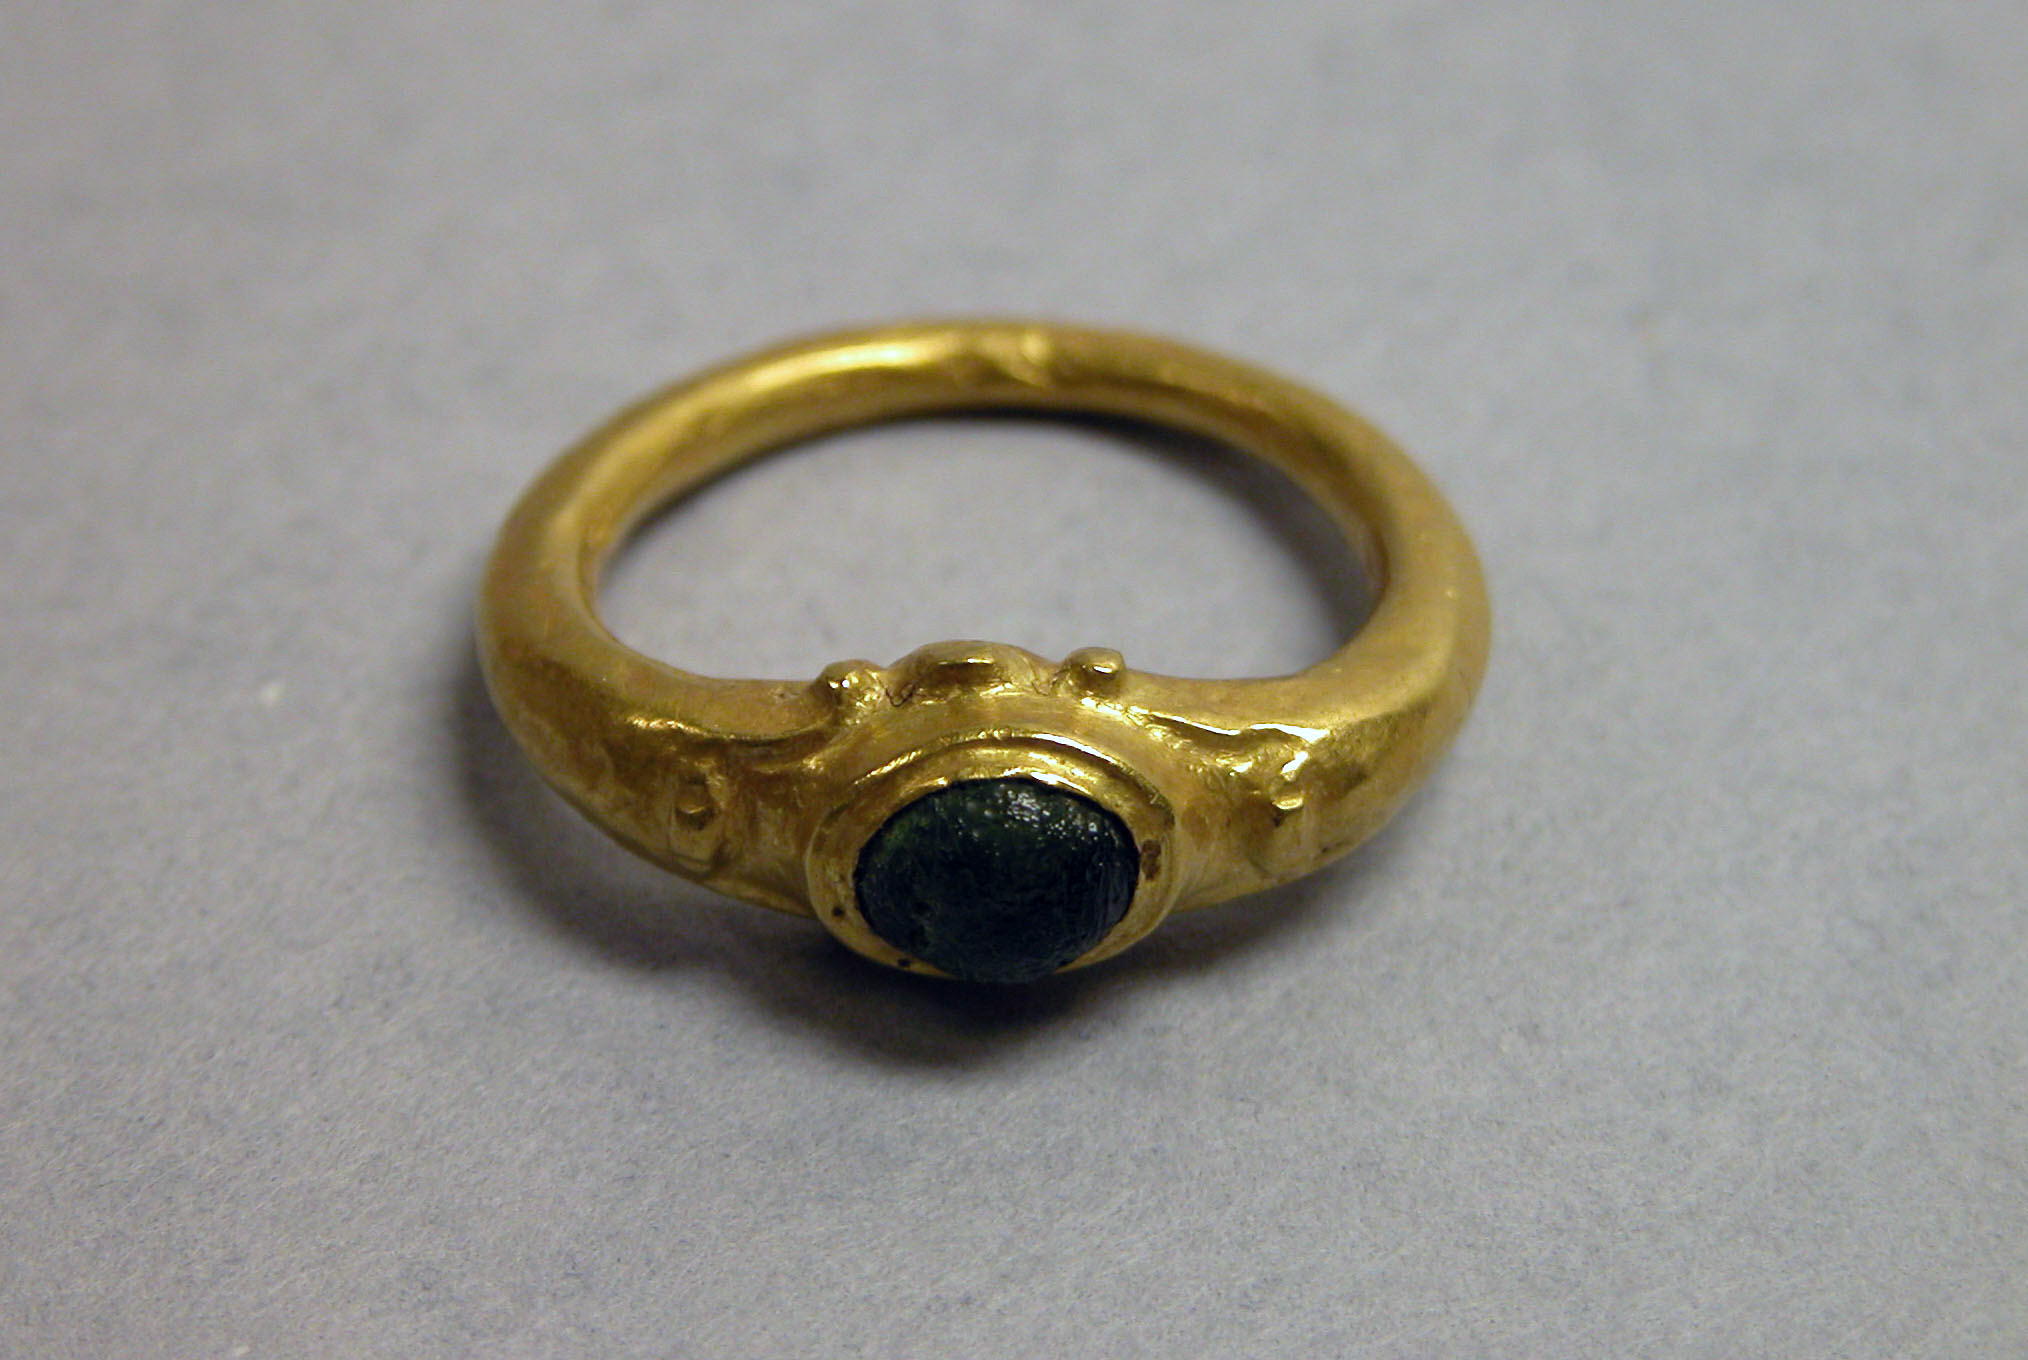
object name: ring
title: Ring with Green Stone in Circular Setting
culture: indonesian, javanese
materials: gold, stone